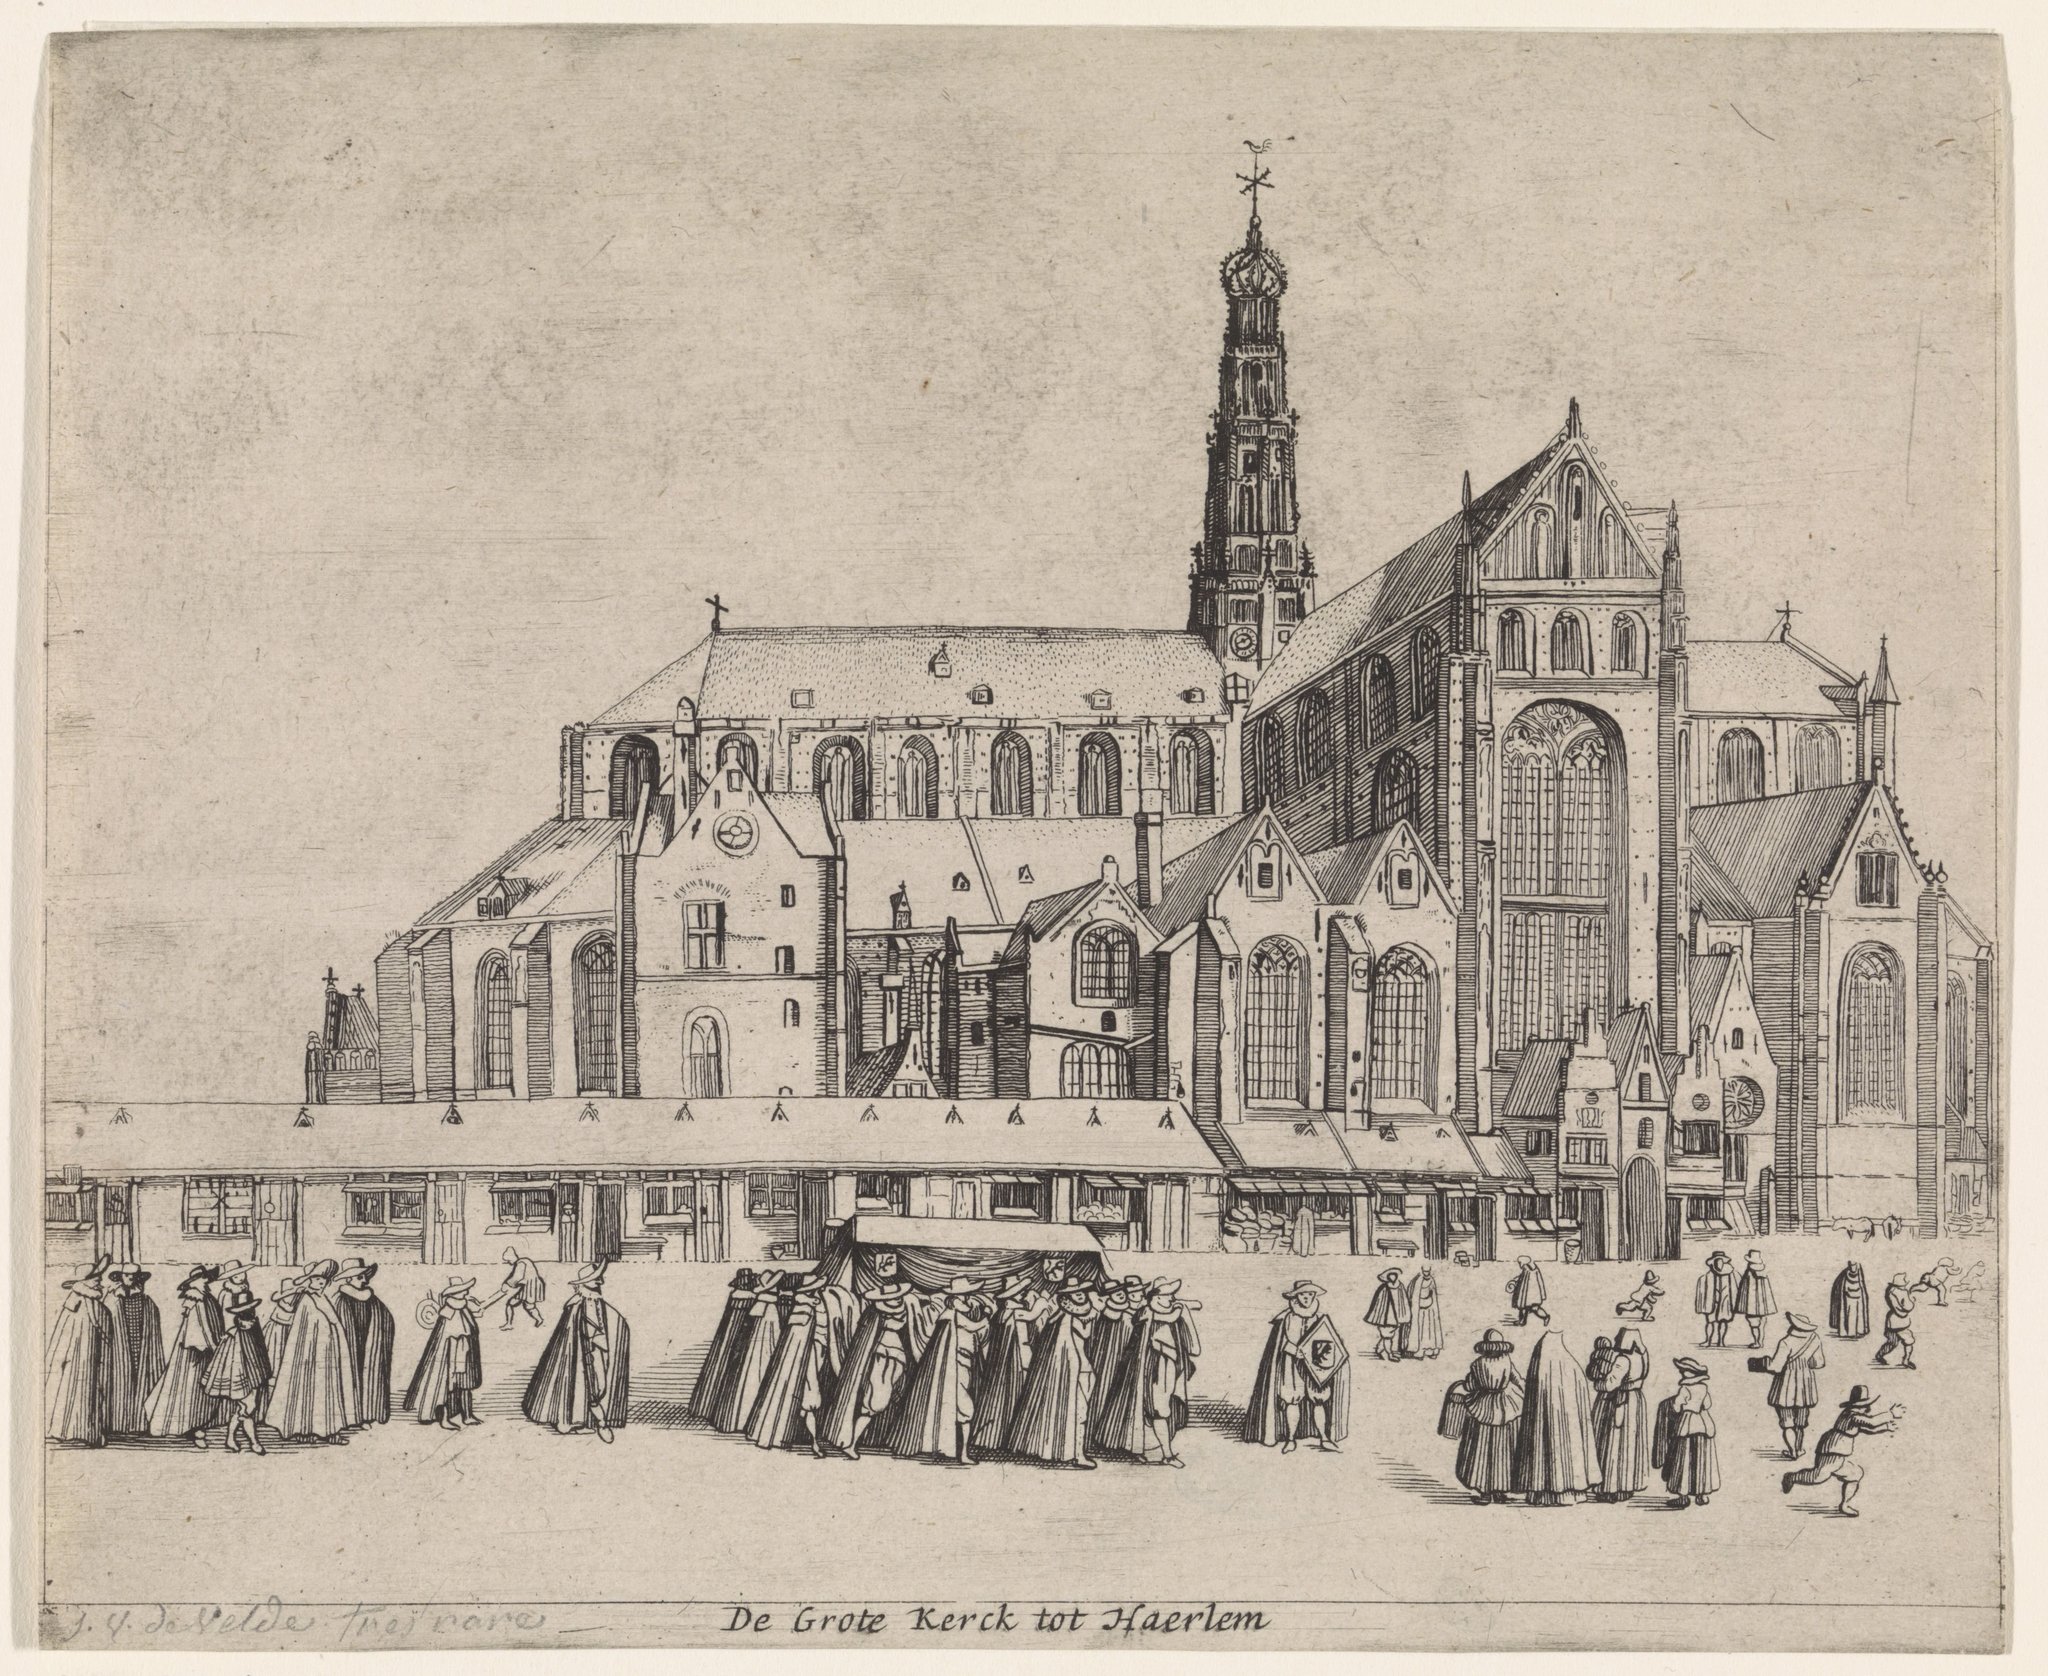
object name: print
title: Gezicht op de Sint-Bavokerk, vanuit het zuidoosten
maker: Anonymous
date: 1628-1678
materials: paper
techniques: etching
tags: church (exterior), public funeral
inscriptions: collector's mark: Lugt 964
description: Kopie in spiegelbeeld van de prent gebruikt in: Ampzing, Samuel. Beschryvinge ende lof der stad Haerlem in Holland […]. Haarlem: Adriaen Roman (I), 1628.